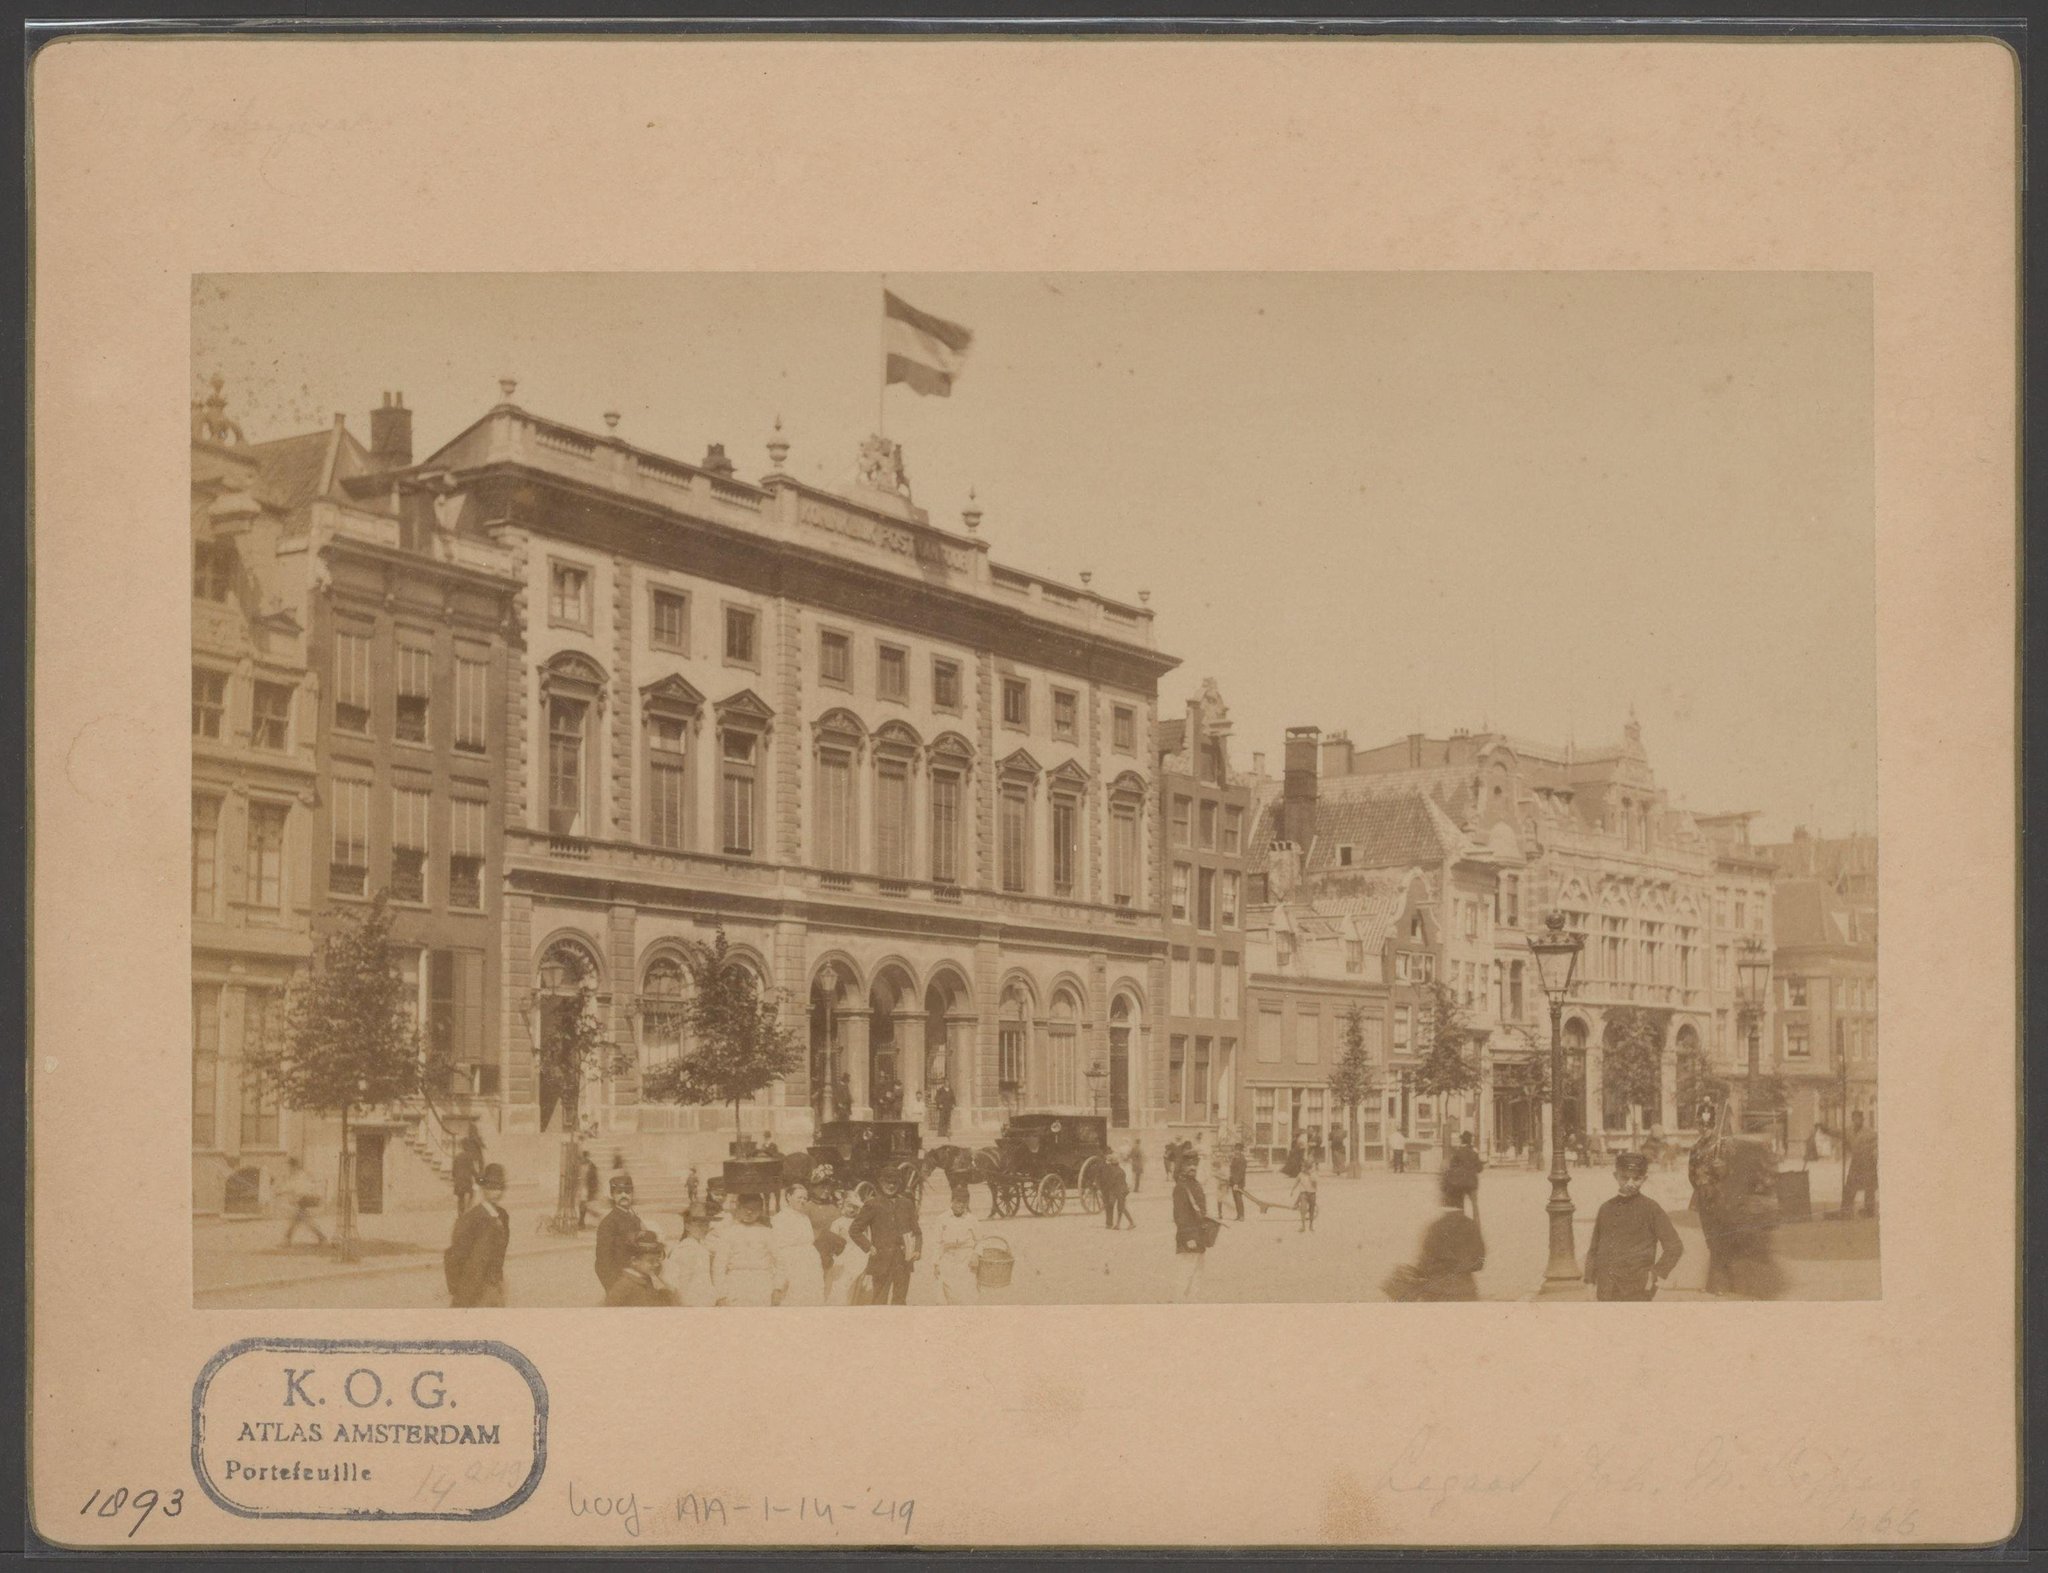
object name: photograph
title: Gezicht op het oude postkantoor aan de Nieuwezijds Voorburgwal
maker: Anonymous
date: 1804-1893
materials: cardboard, paper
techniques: albumen print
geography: amsterdam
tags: post-office, city-view in general; 'veduta', street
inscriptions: collector's mark: ‘14a 49’ Lugt 1641b, inscription: ‘Legaat Joh. M. Coffeng / 1966’, date: ‘April 1893’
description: Onderwerpsrubriek binnen de Atlas Amsterdam: Verhulststraat (Johannes), Viaducten, Vierwindenstraat, Vinkenbuurt, Vinkenpad, Vinkenstraat, Vischsteeg, Vliegendesteeg, Voetboogstraat, Volewijk, Vondelstraat, Voorburgwal (N.Z.).